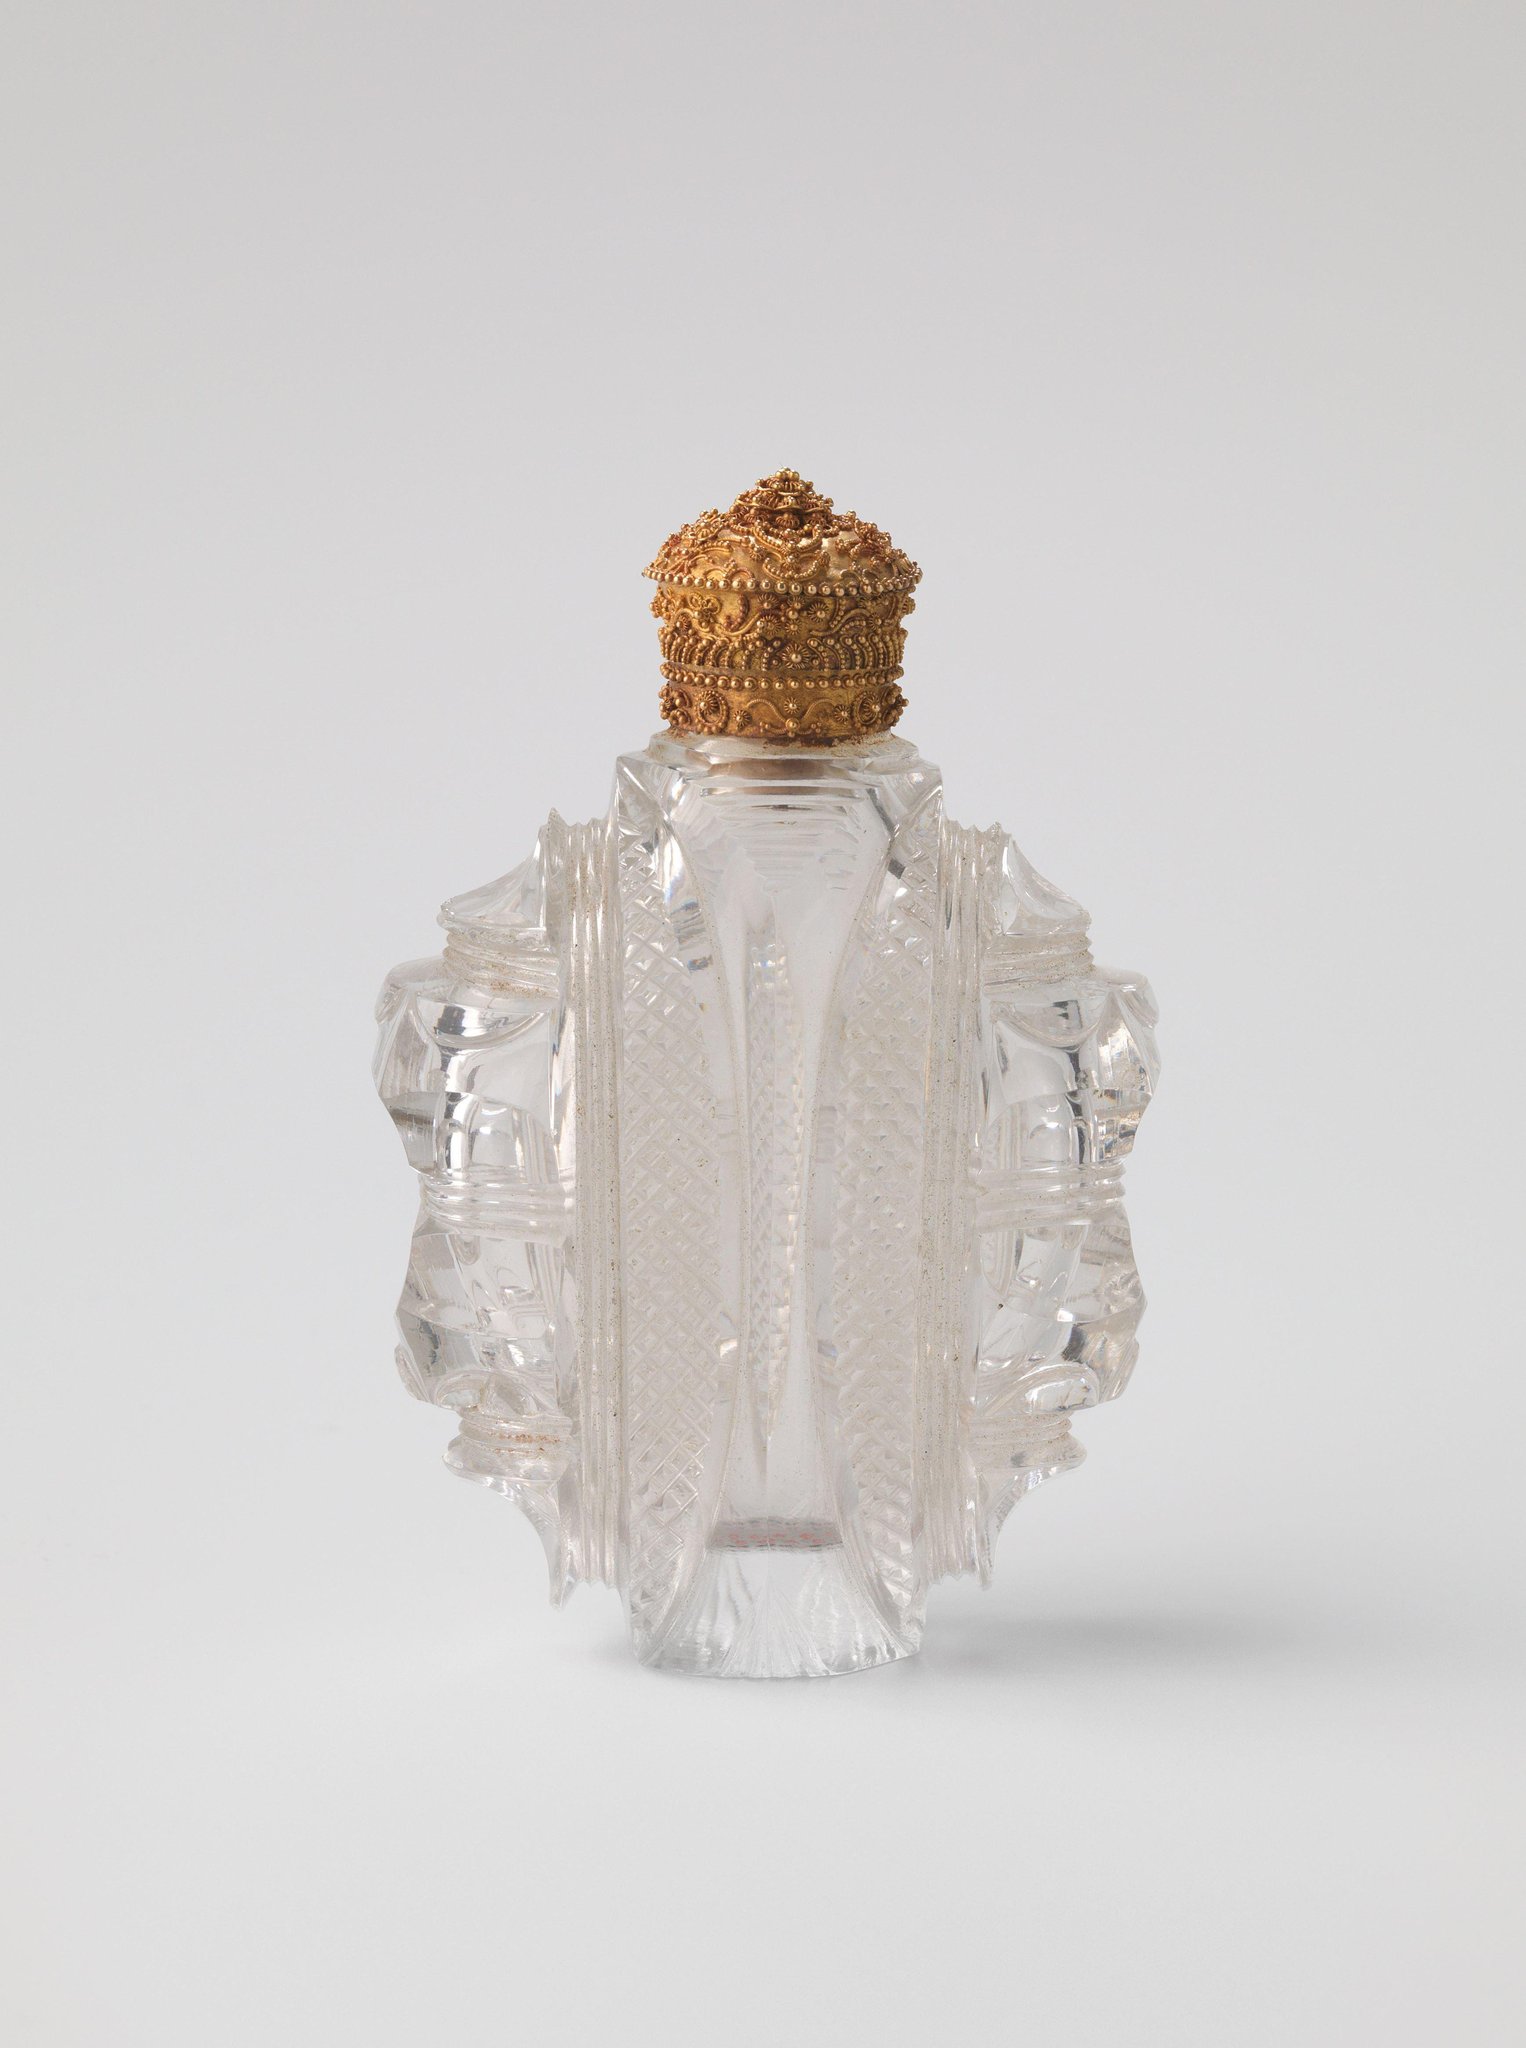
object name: bottle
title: Fles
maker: Anonymous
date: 1830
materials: gold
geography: netherlands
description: Fles van kristal met een gouden dop. De dop is versierd met opgelegde granulé-ornamenten.